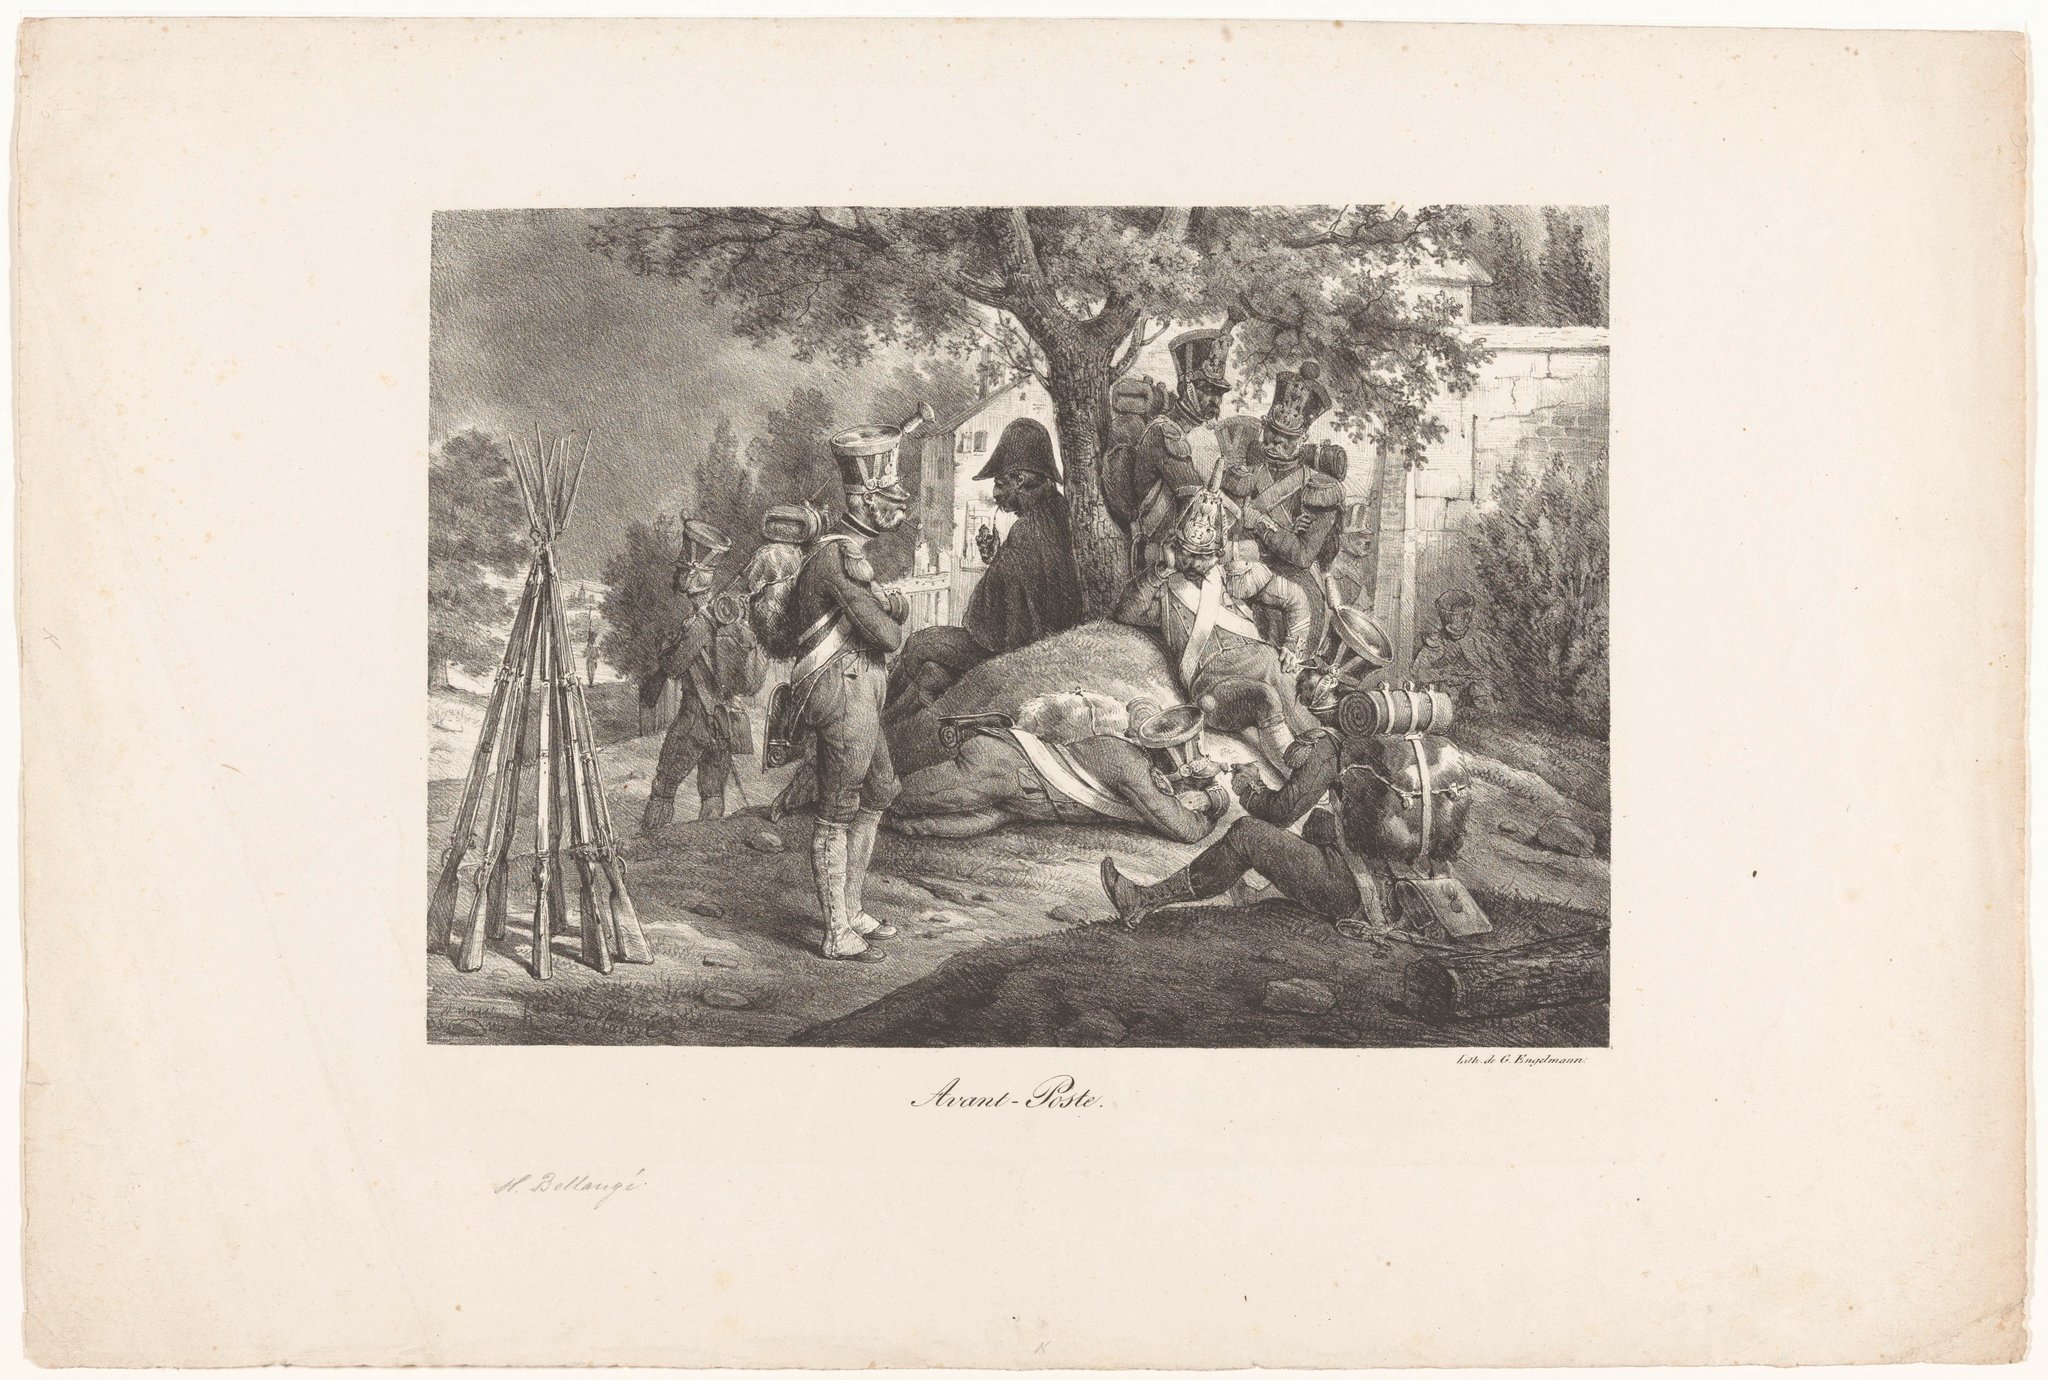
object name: print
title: Avant-Poste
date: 1821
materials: paper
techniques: lithograph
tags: the soldier; the soldier's life, resting - bb - out of doors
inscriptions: collector's mark: Lugt 2228a, annotation: ‘Adeline no. 347.2. Breit 0,319. Hohe 0,225.’